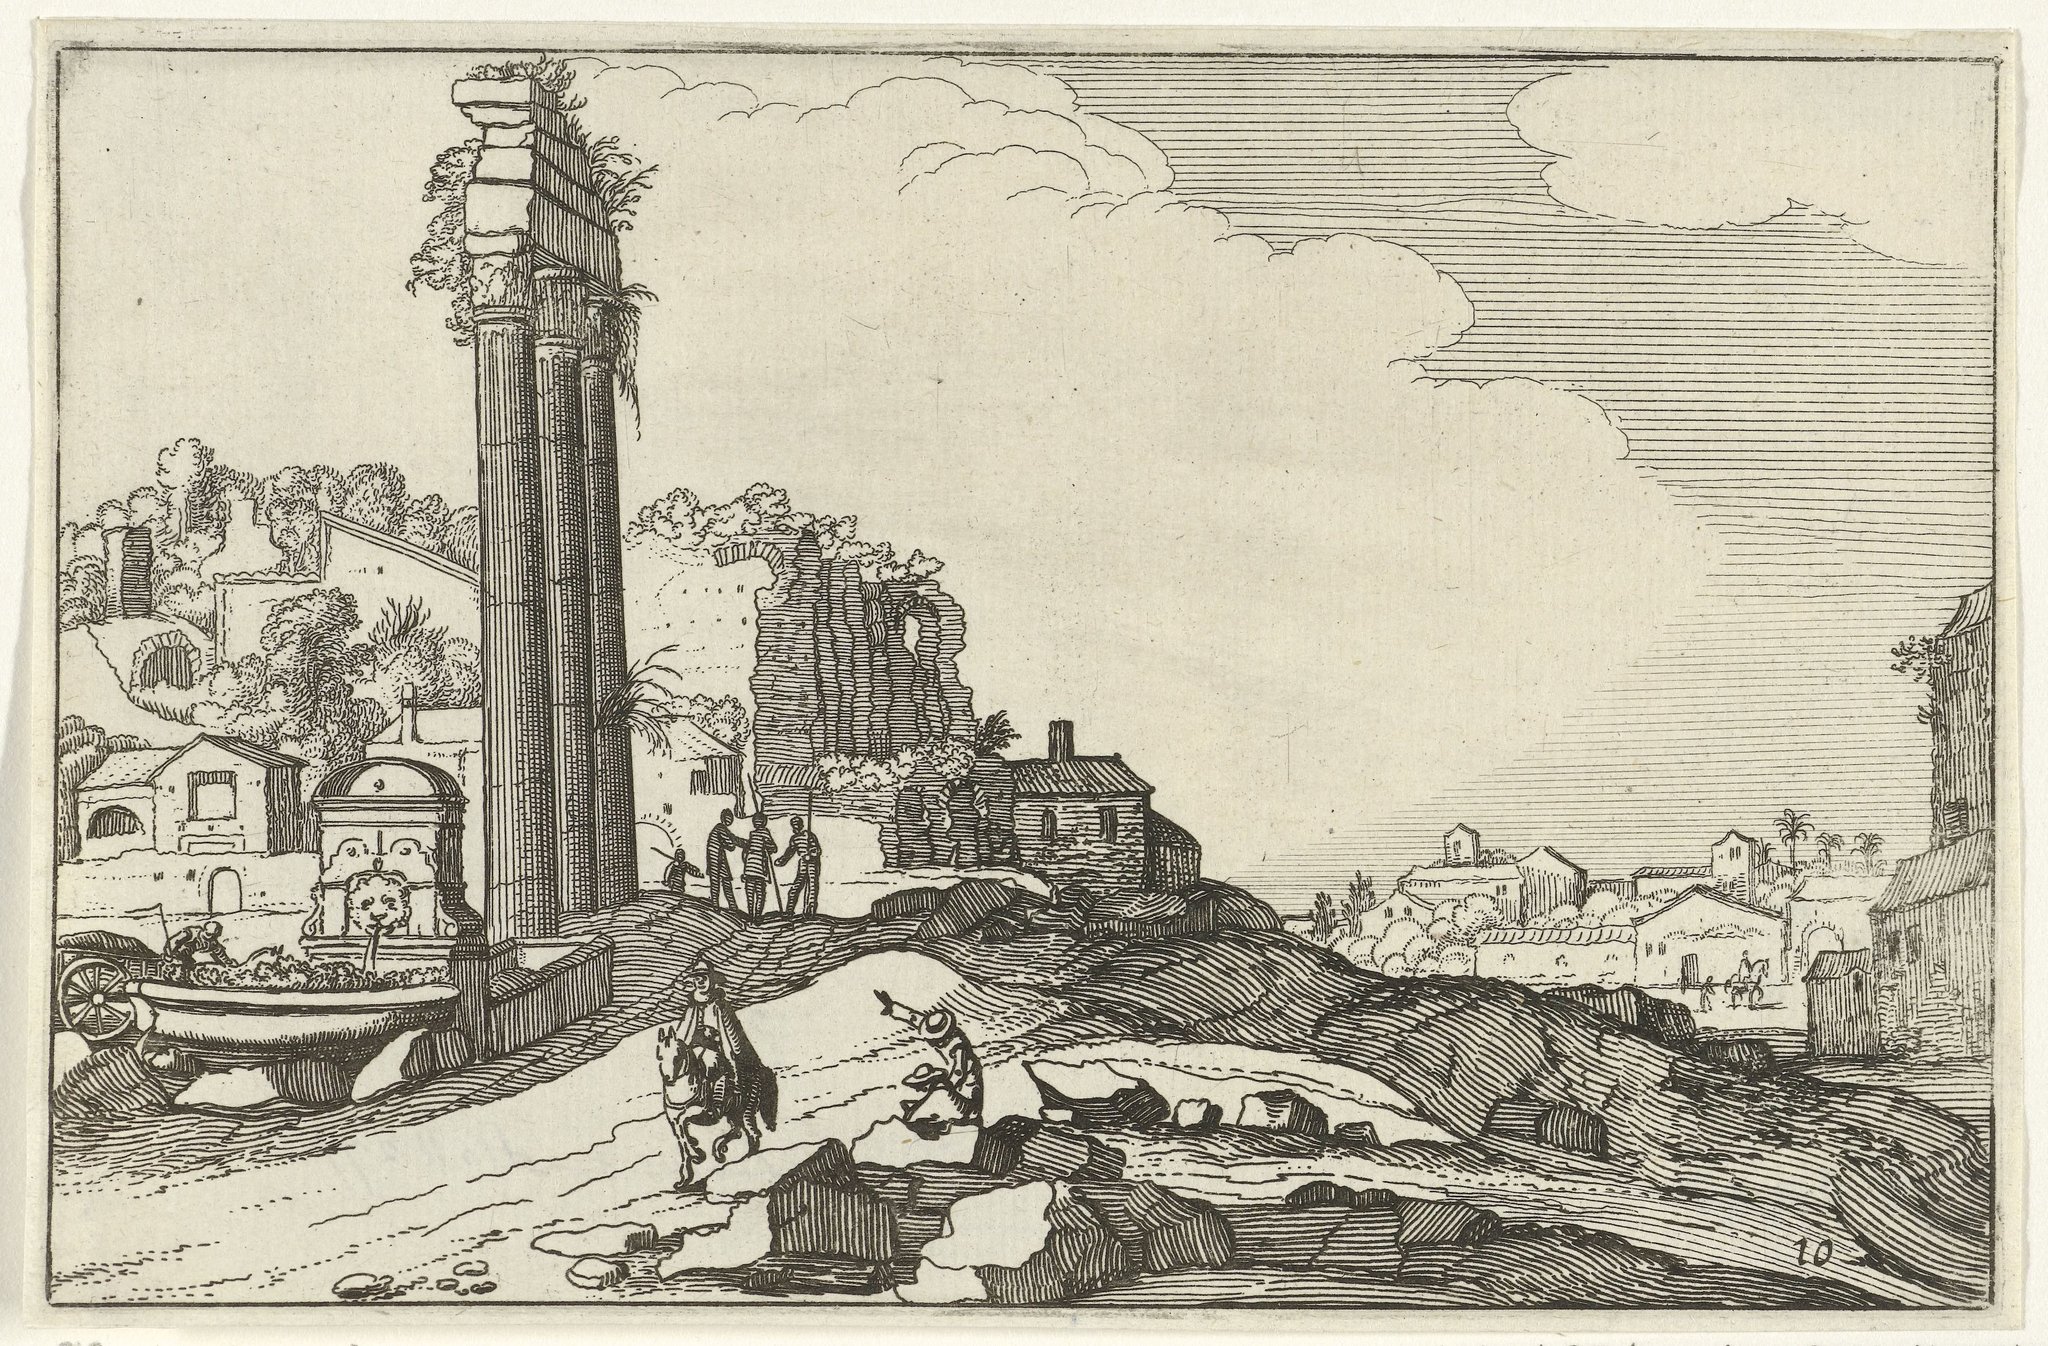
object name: print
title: Romeinse ruïnes en kustlandschappen (serie 1)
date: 1618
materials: paper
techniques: etching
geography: amsterdam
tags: ruin of a building ~ architecture, landscape with ruins, rome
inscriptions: collector's mark: Lugt 2228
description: De ruïne van de tempel van Castor en Pollux op het Forum Romanum in Rome. Daarnaast enkele figuren en een fontein. Op de weg rijdt een man te paard. Prent maakt deel uit van een serie Romeinse ruïnes en kustlandschappen naar een prentserie van Willem van Nieulandt.